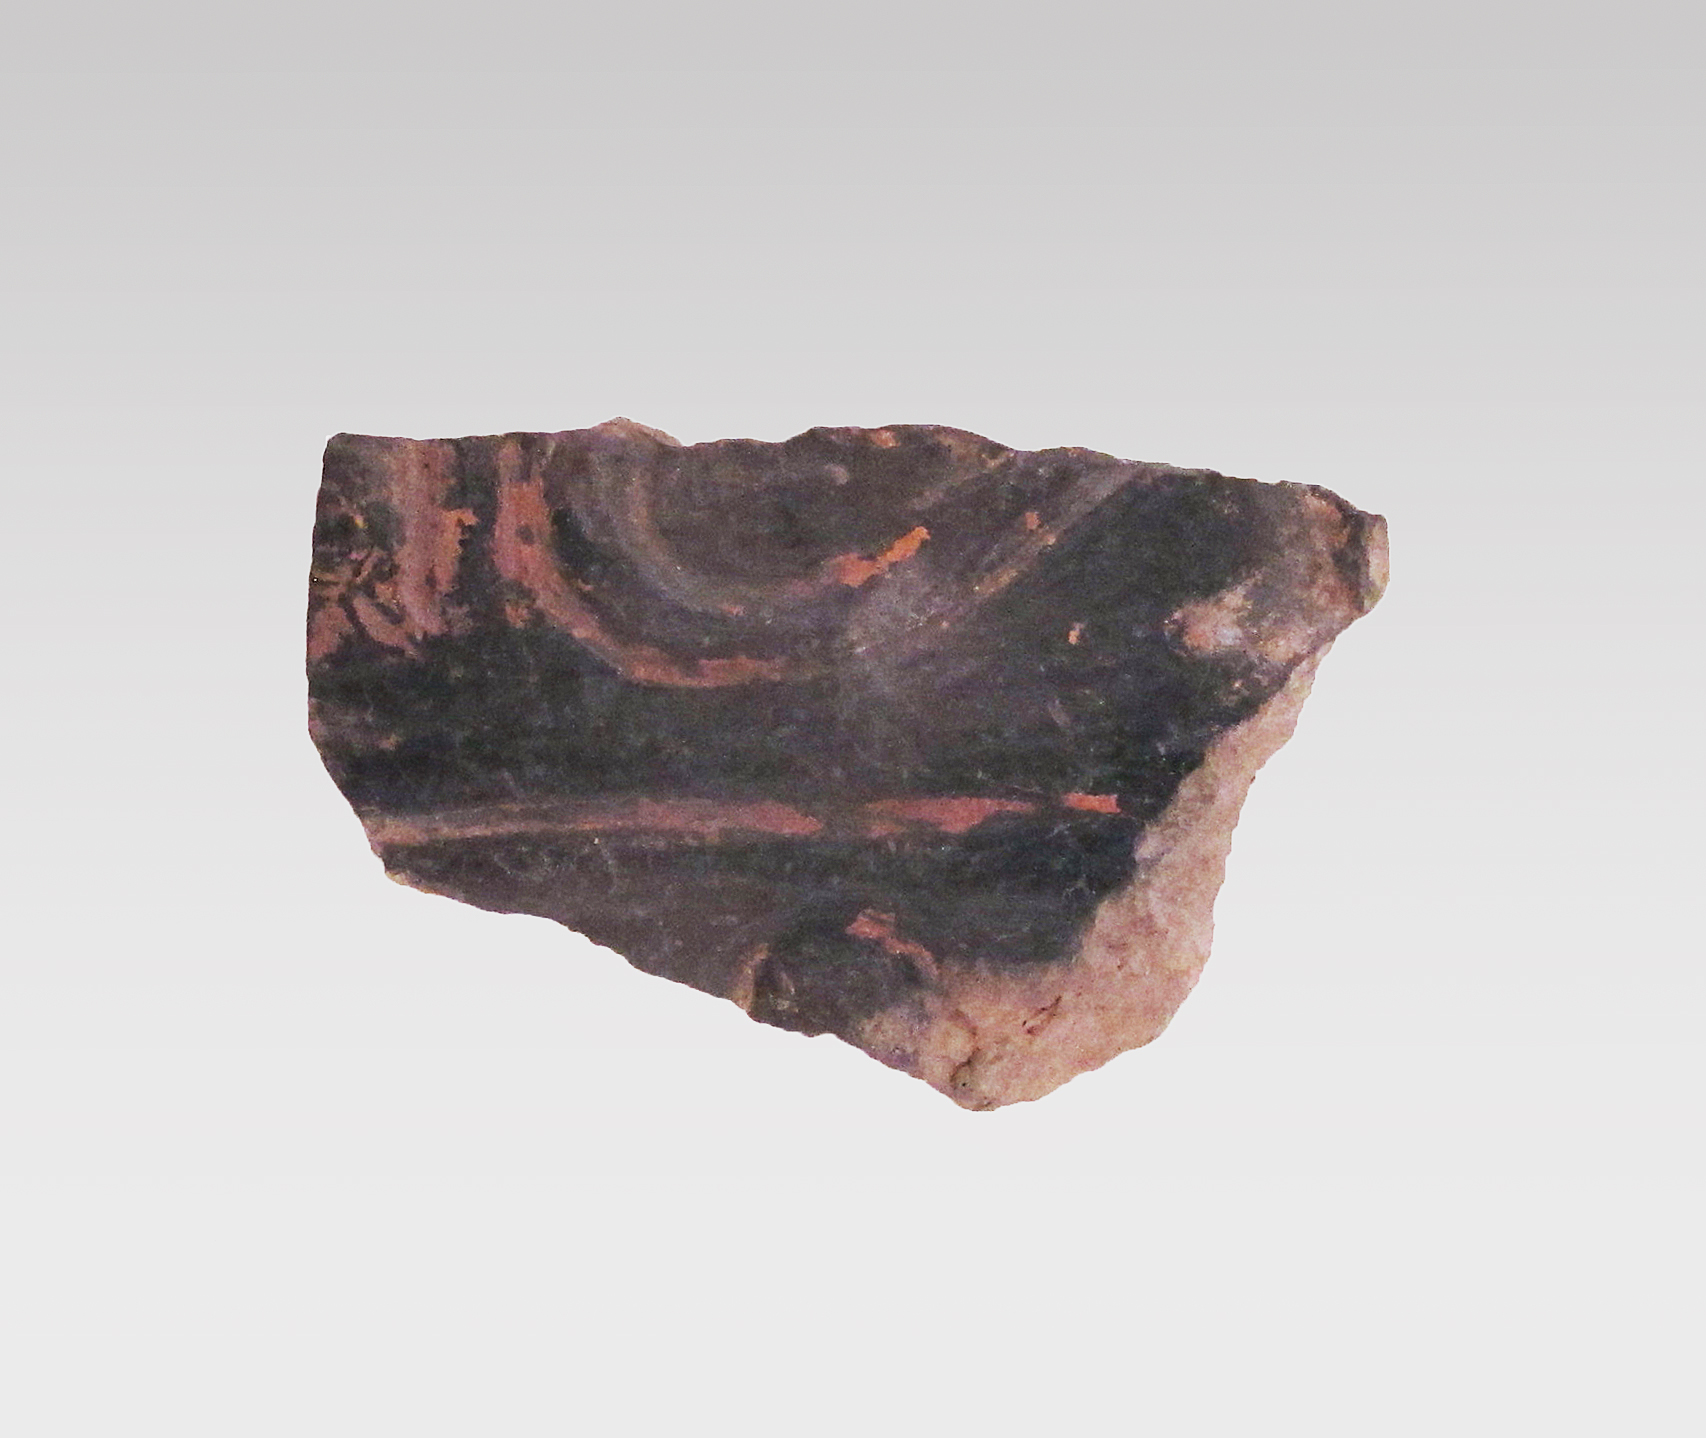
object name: vase fragment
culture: etruscan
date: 575-550 BCE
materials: terracotta